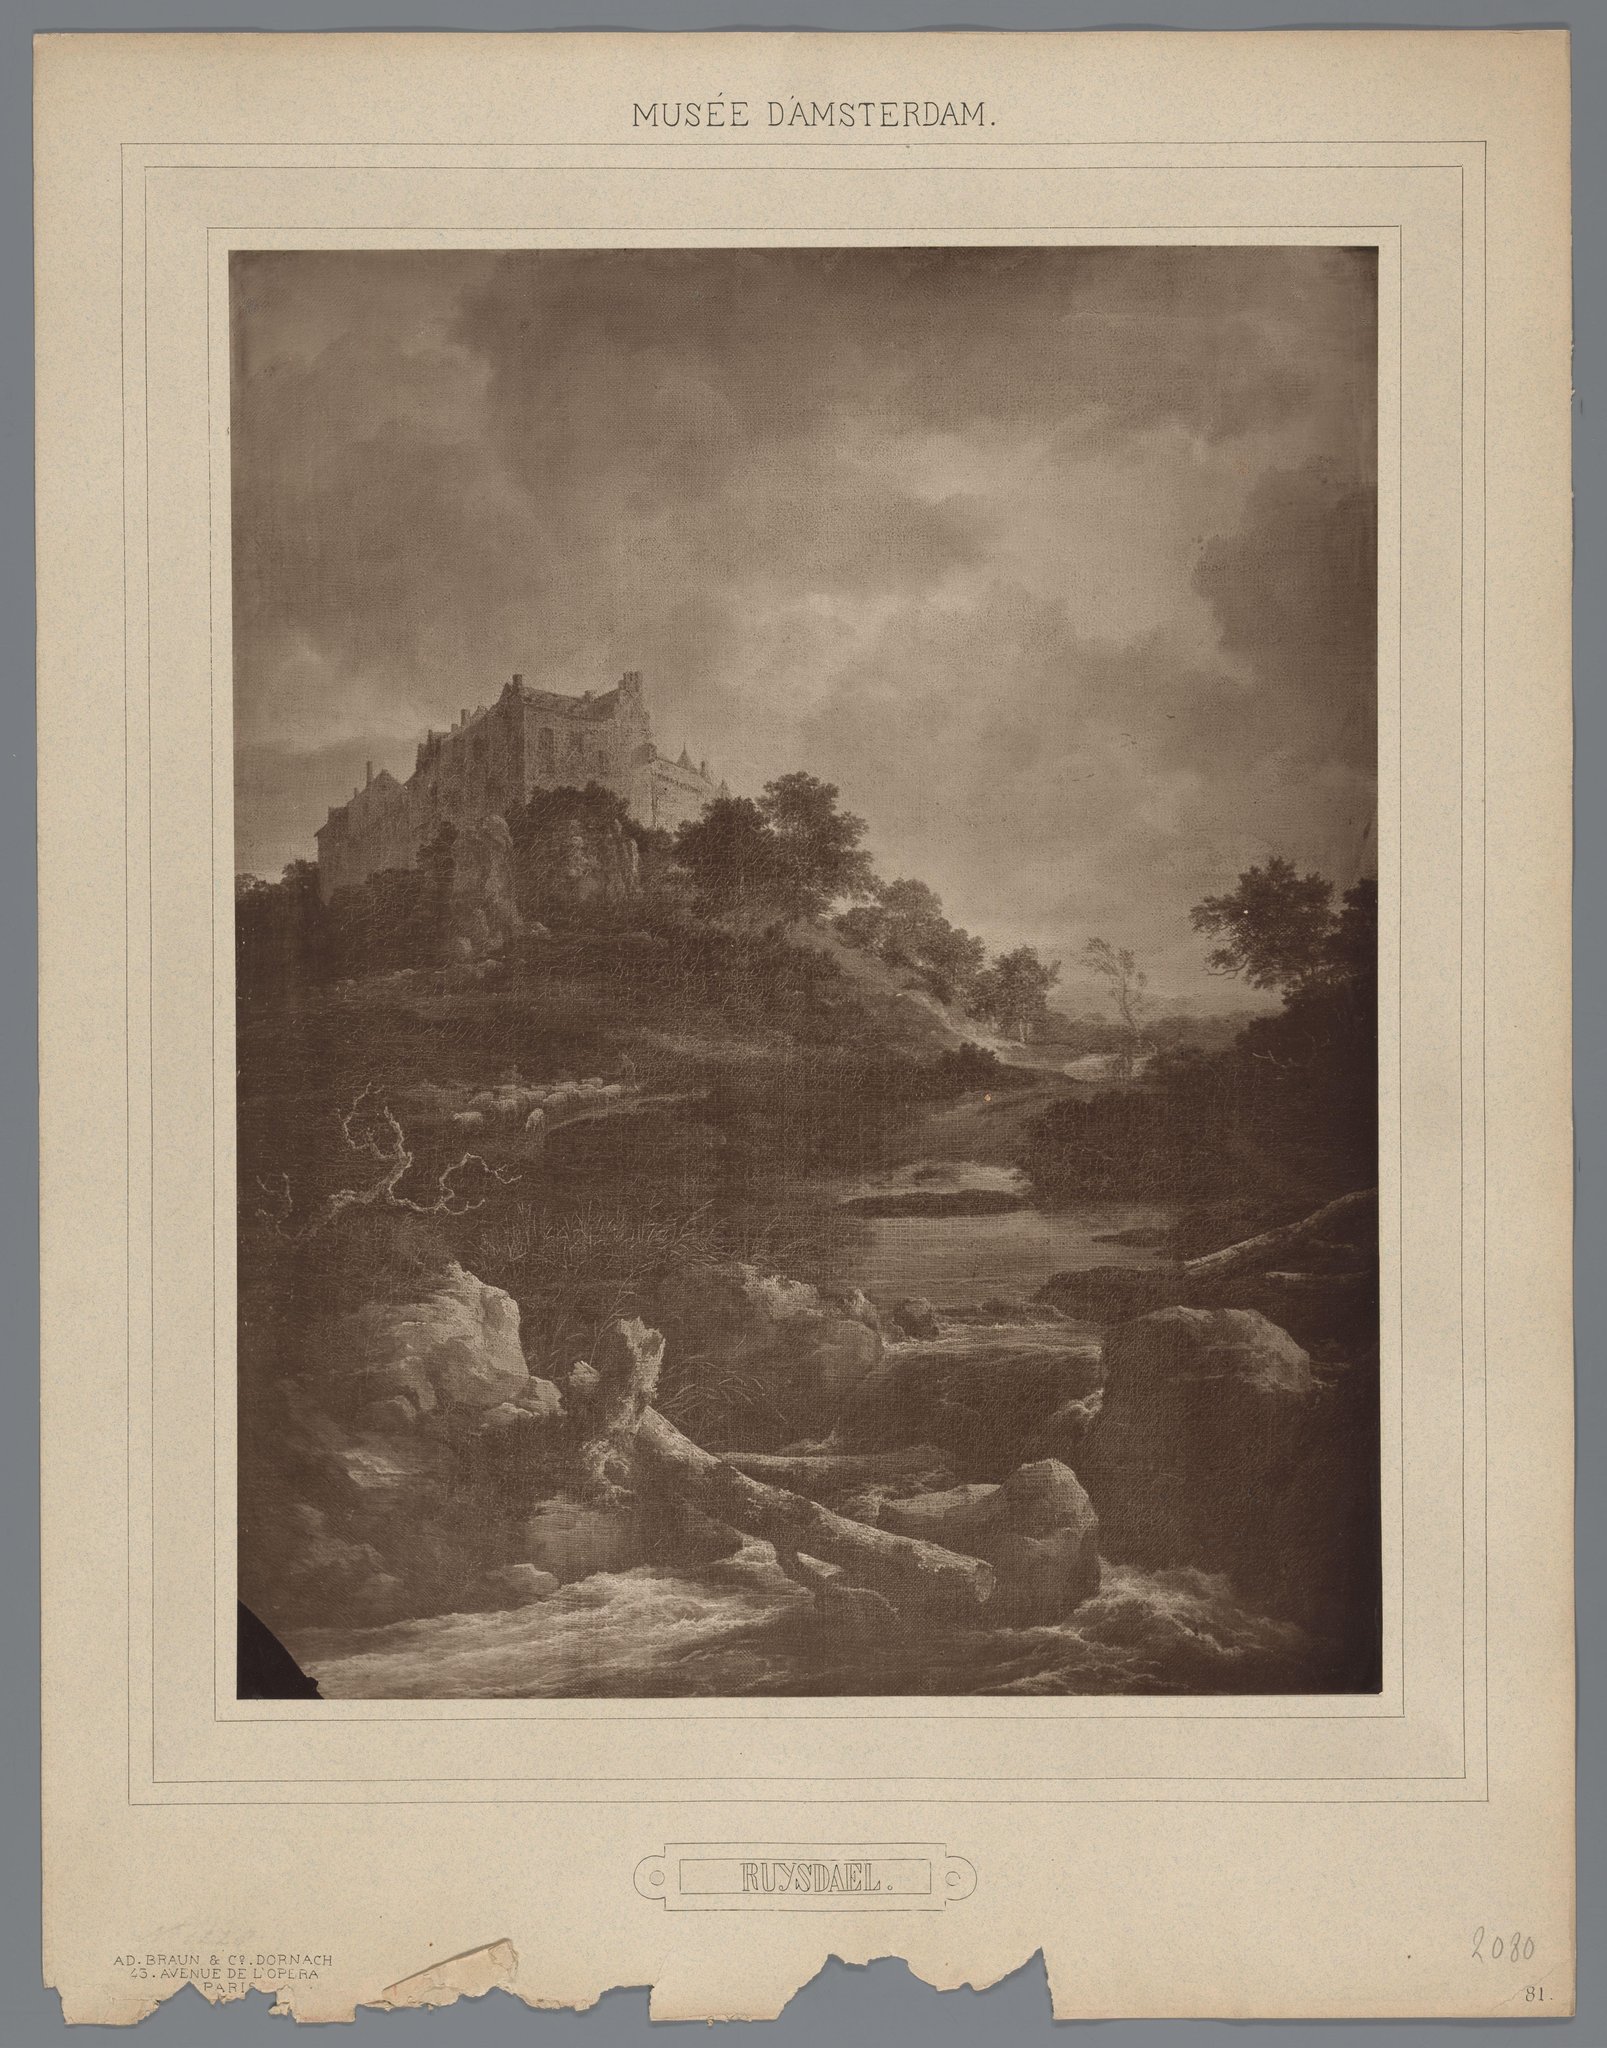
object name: photograph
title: Fotoreproductie van een schilderij van Jacob van Ruisdael, 'Kasteel Bentheim' (coll. Rijksmuseum)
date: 1880-1900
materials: cardboard, paper, photographic support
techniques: carbon print